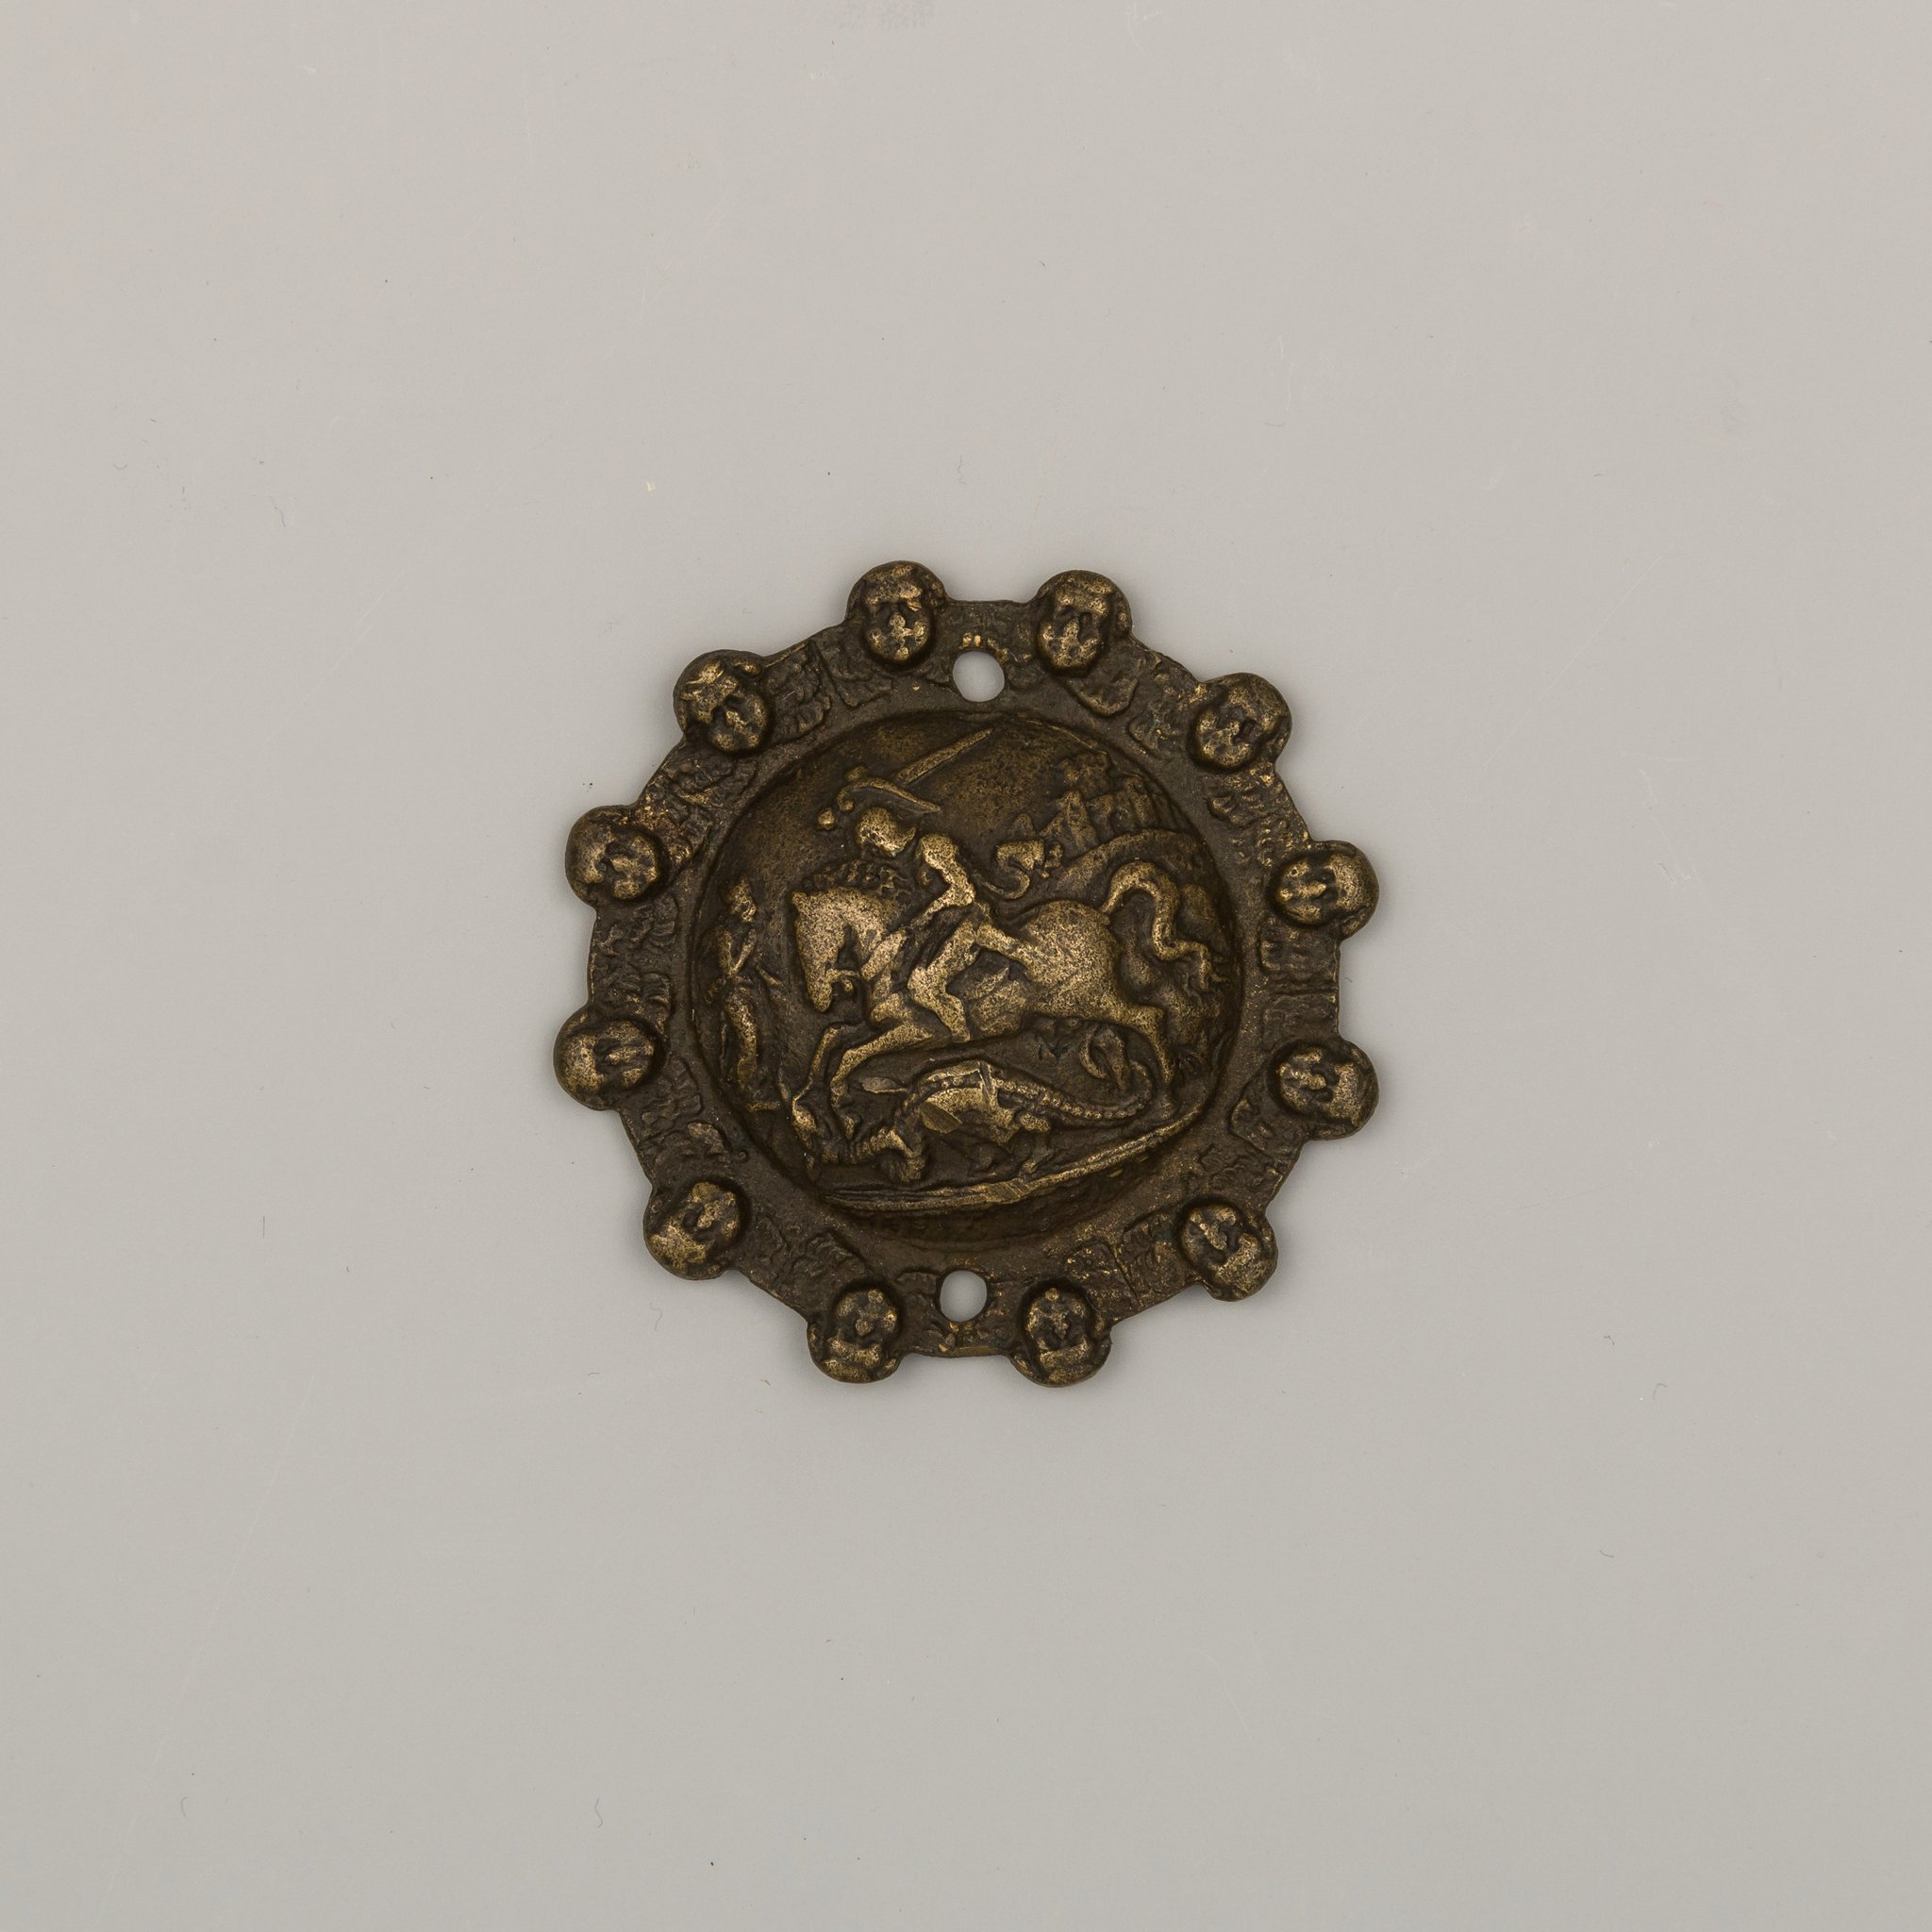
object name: bit bos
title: Bit Boss with Saint George and the Dragon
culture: italian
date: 1551-1600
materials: copper alloy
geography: italy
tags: dragons,horses,saint george